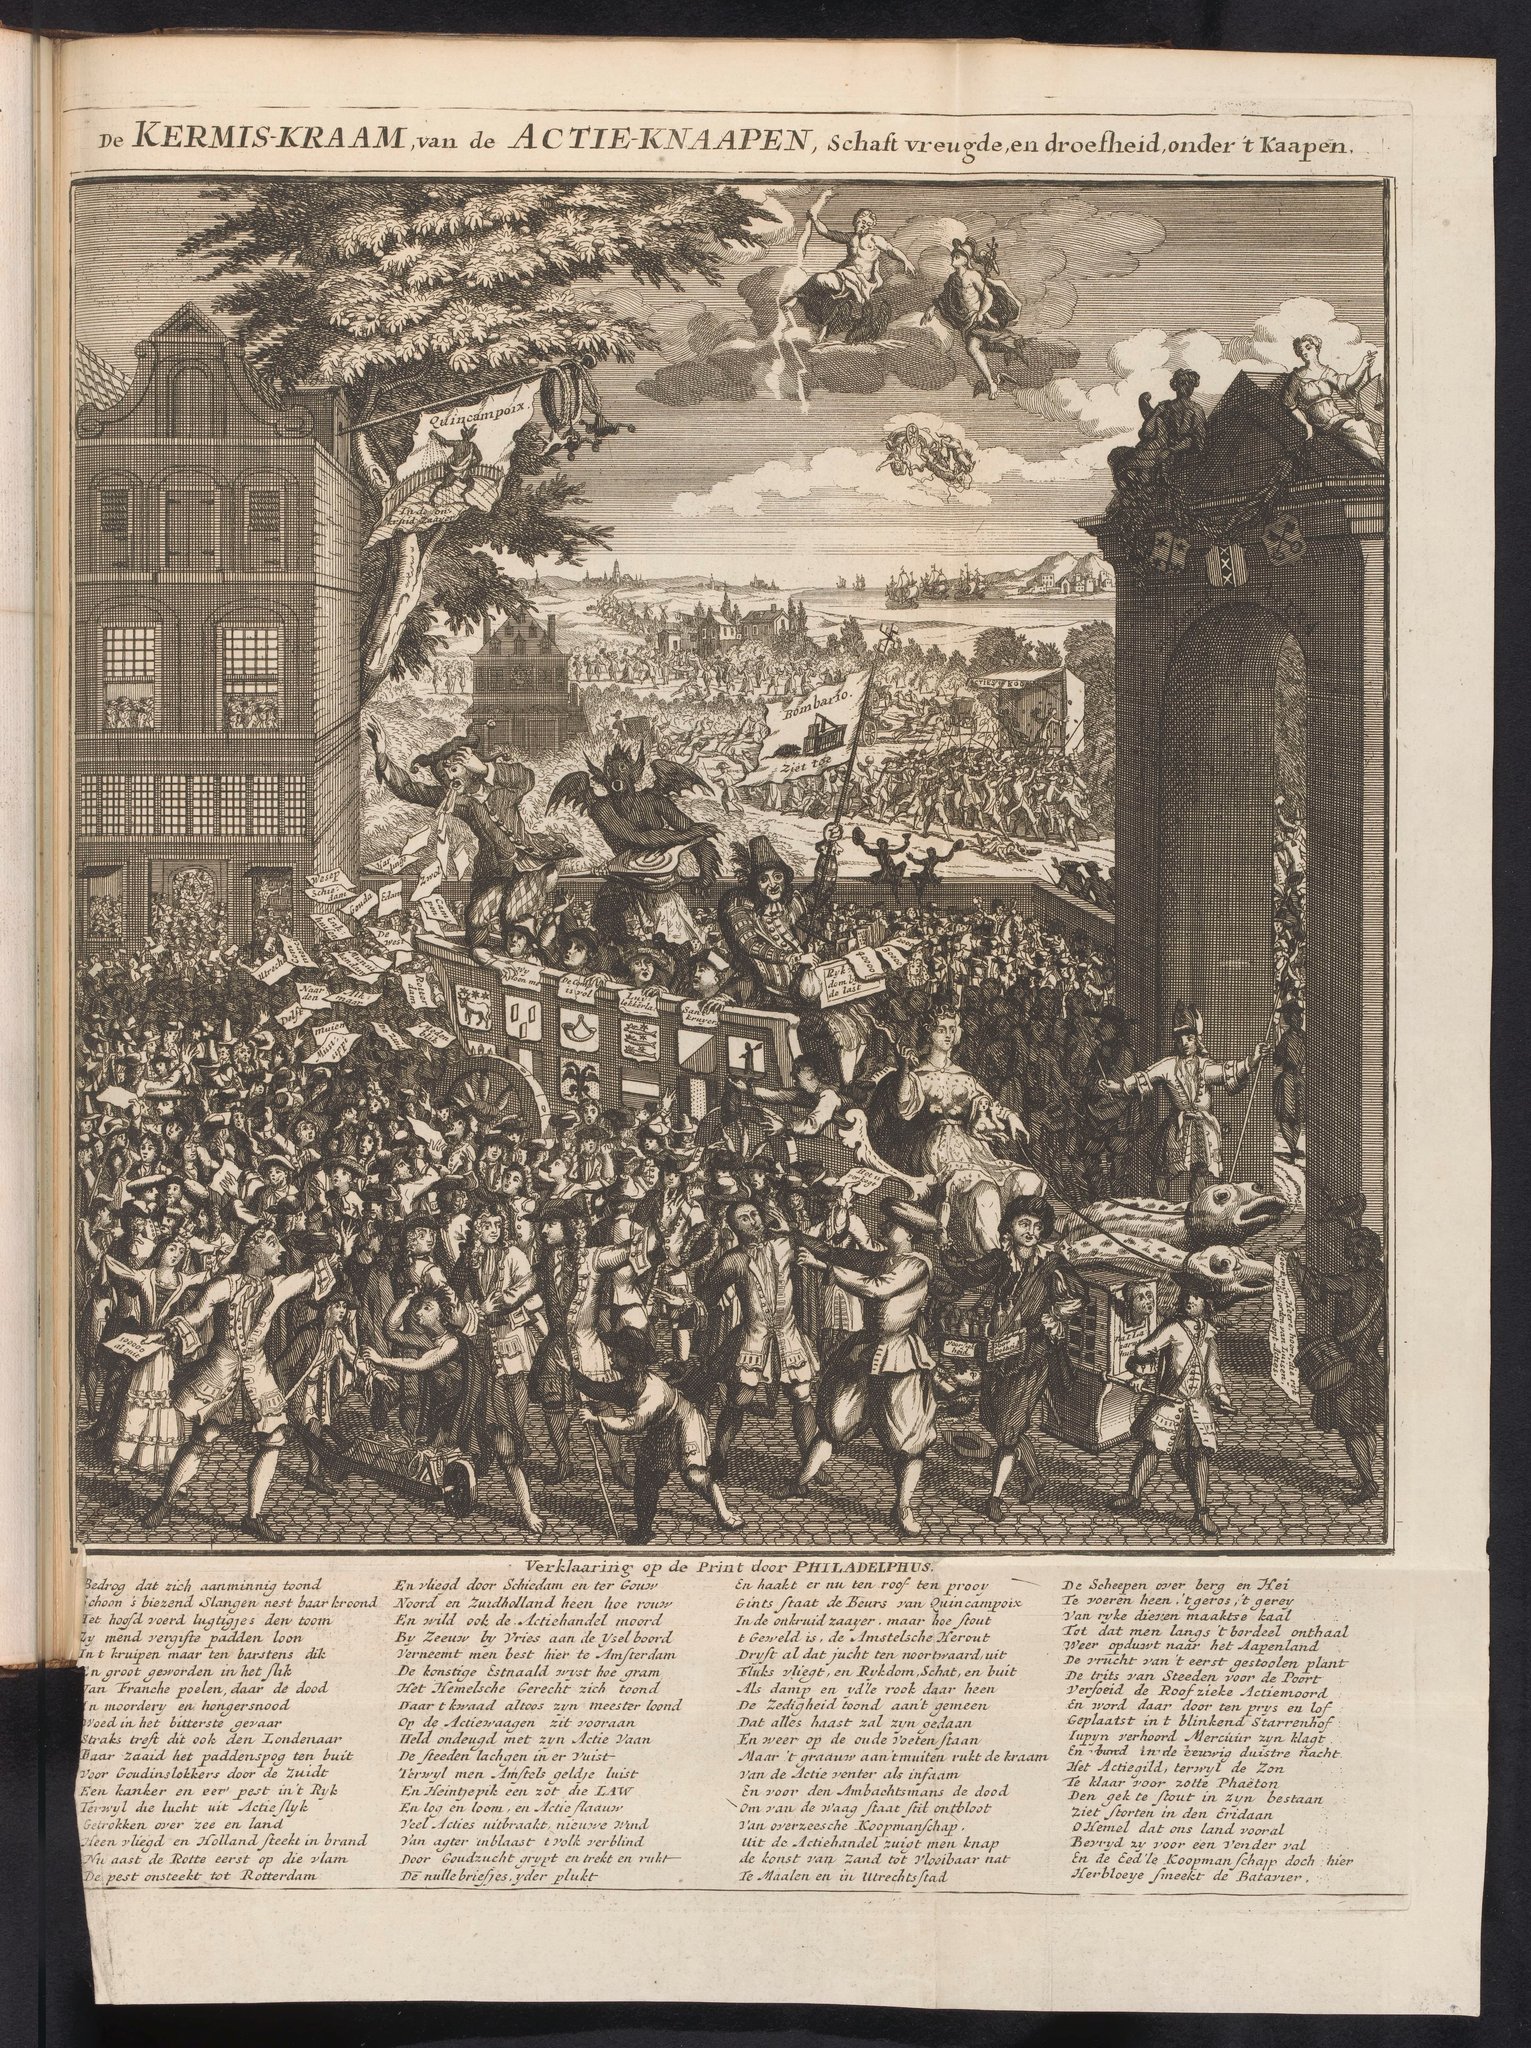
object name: print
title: De Kermis-kraam, van de Actie-knaapen, Schaft vreugde, en droefheid, onder 't Kaapen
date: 1720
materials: paper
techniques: etching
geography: northern netherlands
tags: financial panic, inn, coffee-house, public house, etc.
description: De kermiskraam van de actiehandelaars. Een grote kar getrokken door twee padden en gemend door Bedrog waarop rijden Bombario (met bochel) in harlekijnskleding, de duivel met een blaasbalg en een nar die aandelen opgeeft. Om de kar en bij het koffiehuis Quincampoix een grote menigte actiehandelaren in paniek. Rechts een poort met de wapens van Haarlem, Amsterdam en Leiden waaraan de kar de toegang wordt ontzegd. In het onderschrift een vers in vier kolommen door Philadelphus. Prent in de gebonden eerste uitgave (304 B 11) van Het Groote Tafereel der Dwaasheid met spotprenten op de Windhandel of Actiehandel van 1720.